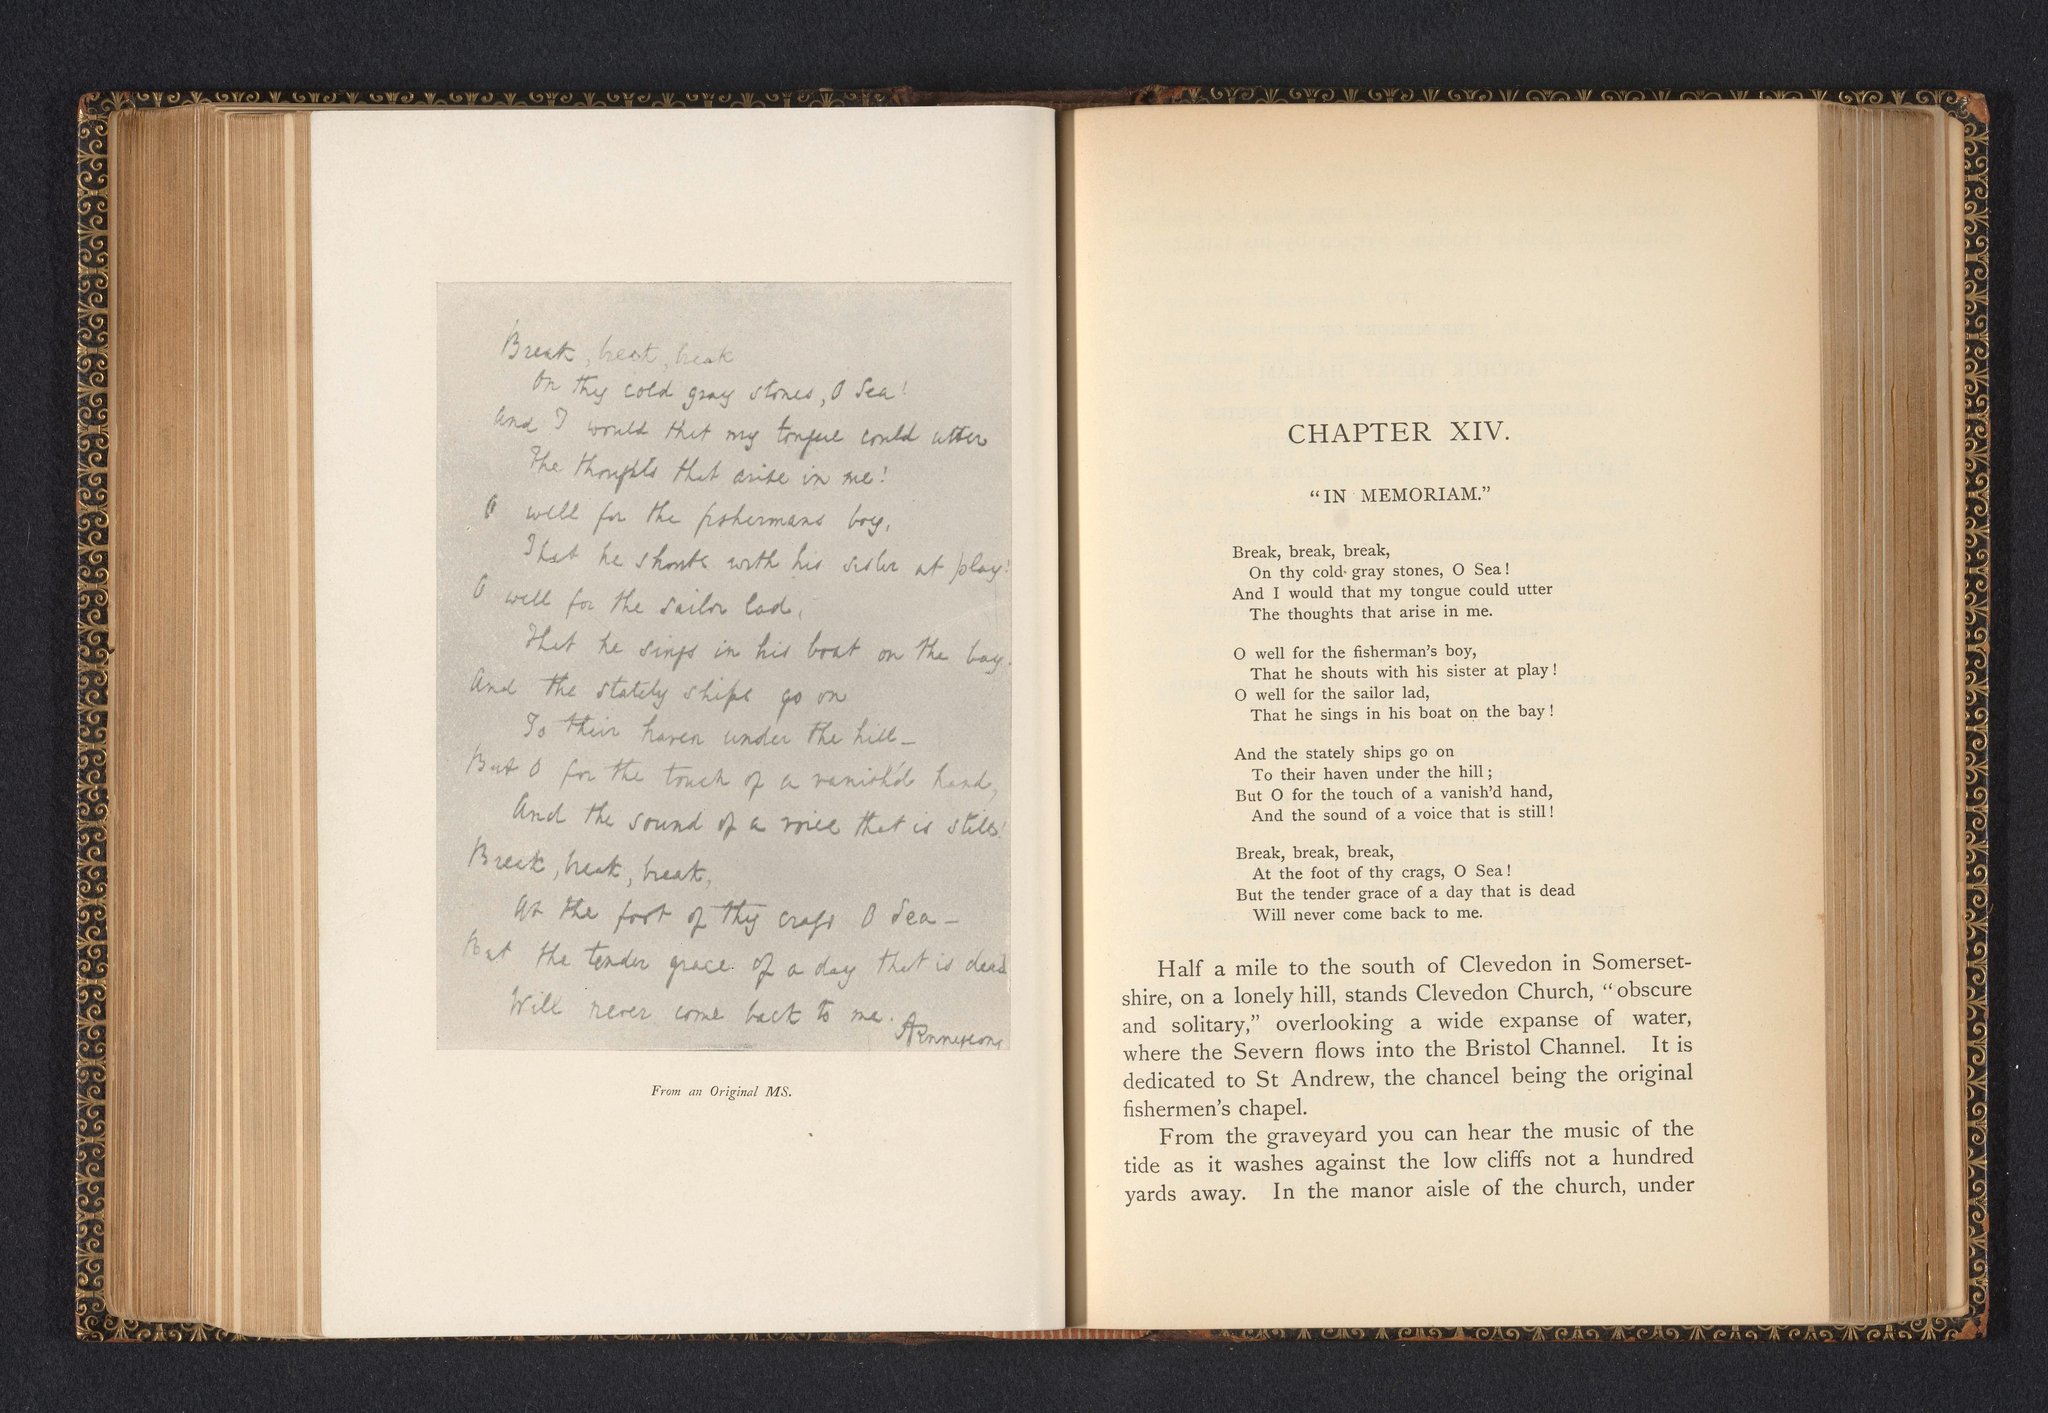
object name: reproduction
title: Fotoreproductie van het gedicht In Memoriam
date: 1887-1897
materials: paper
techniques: autotype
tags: handwriting, written text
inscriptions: inscription: ‘From an original MS.’